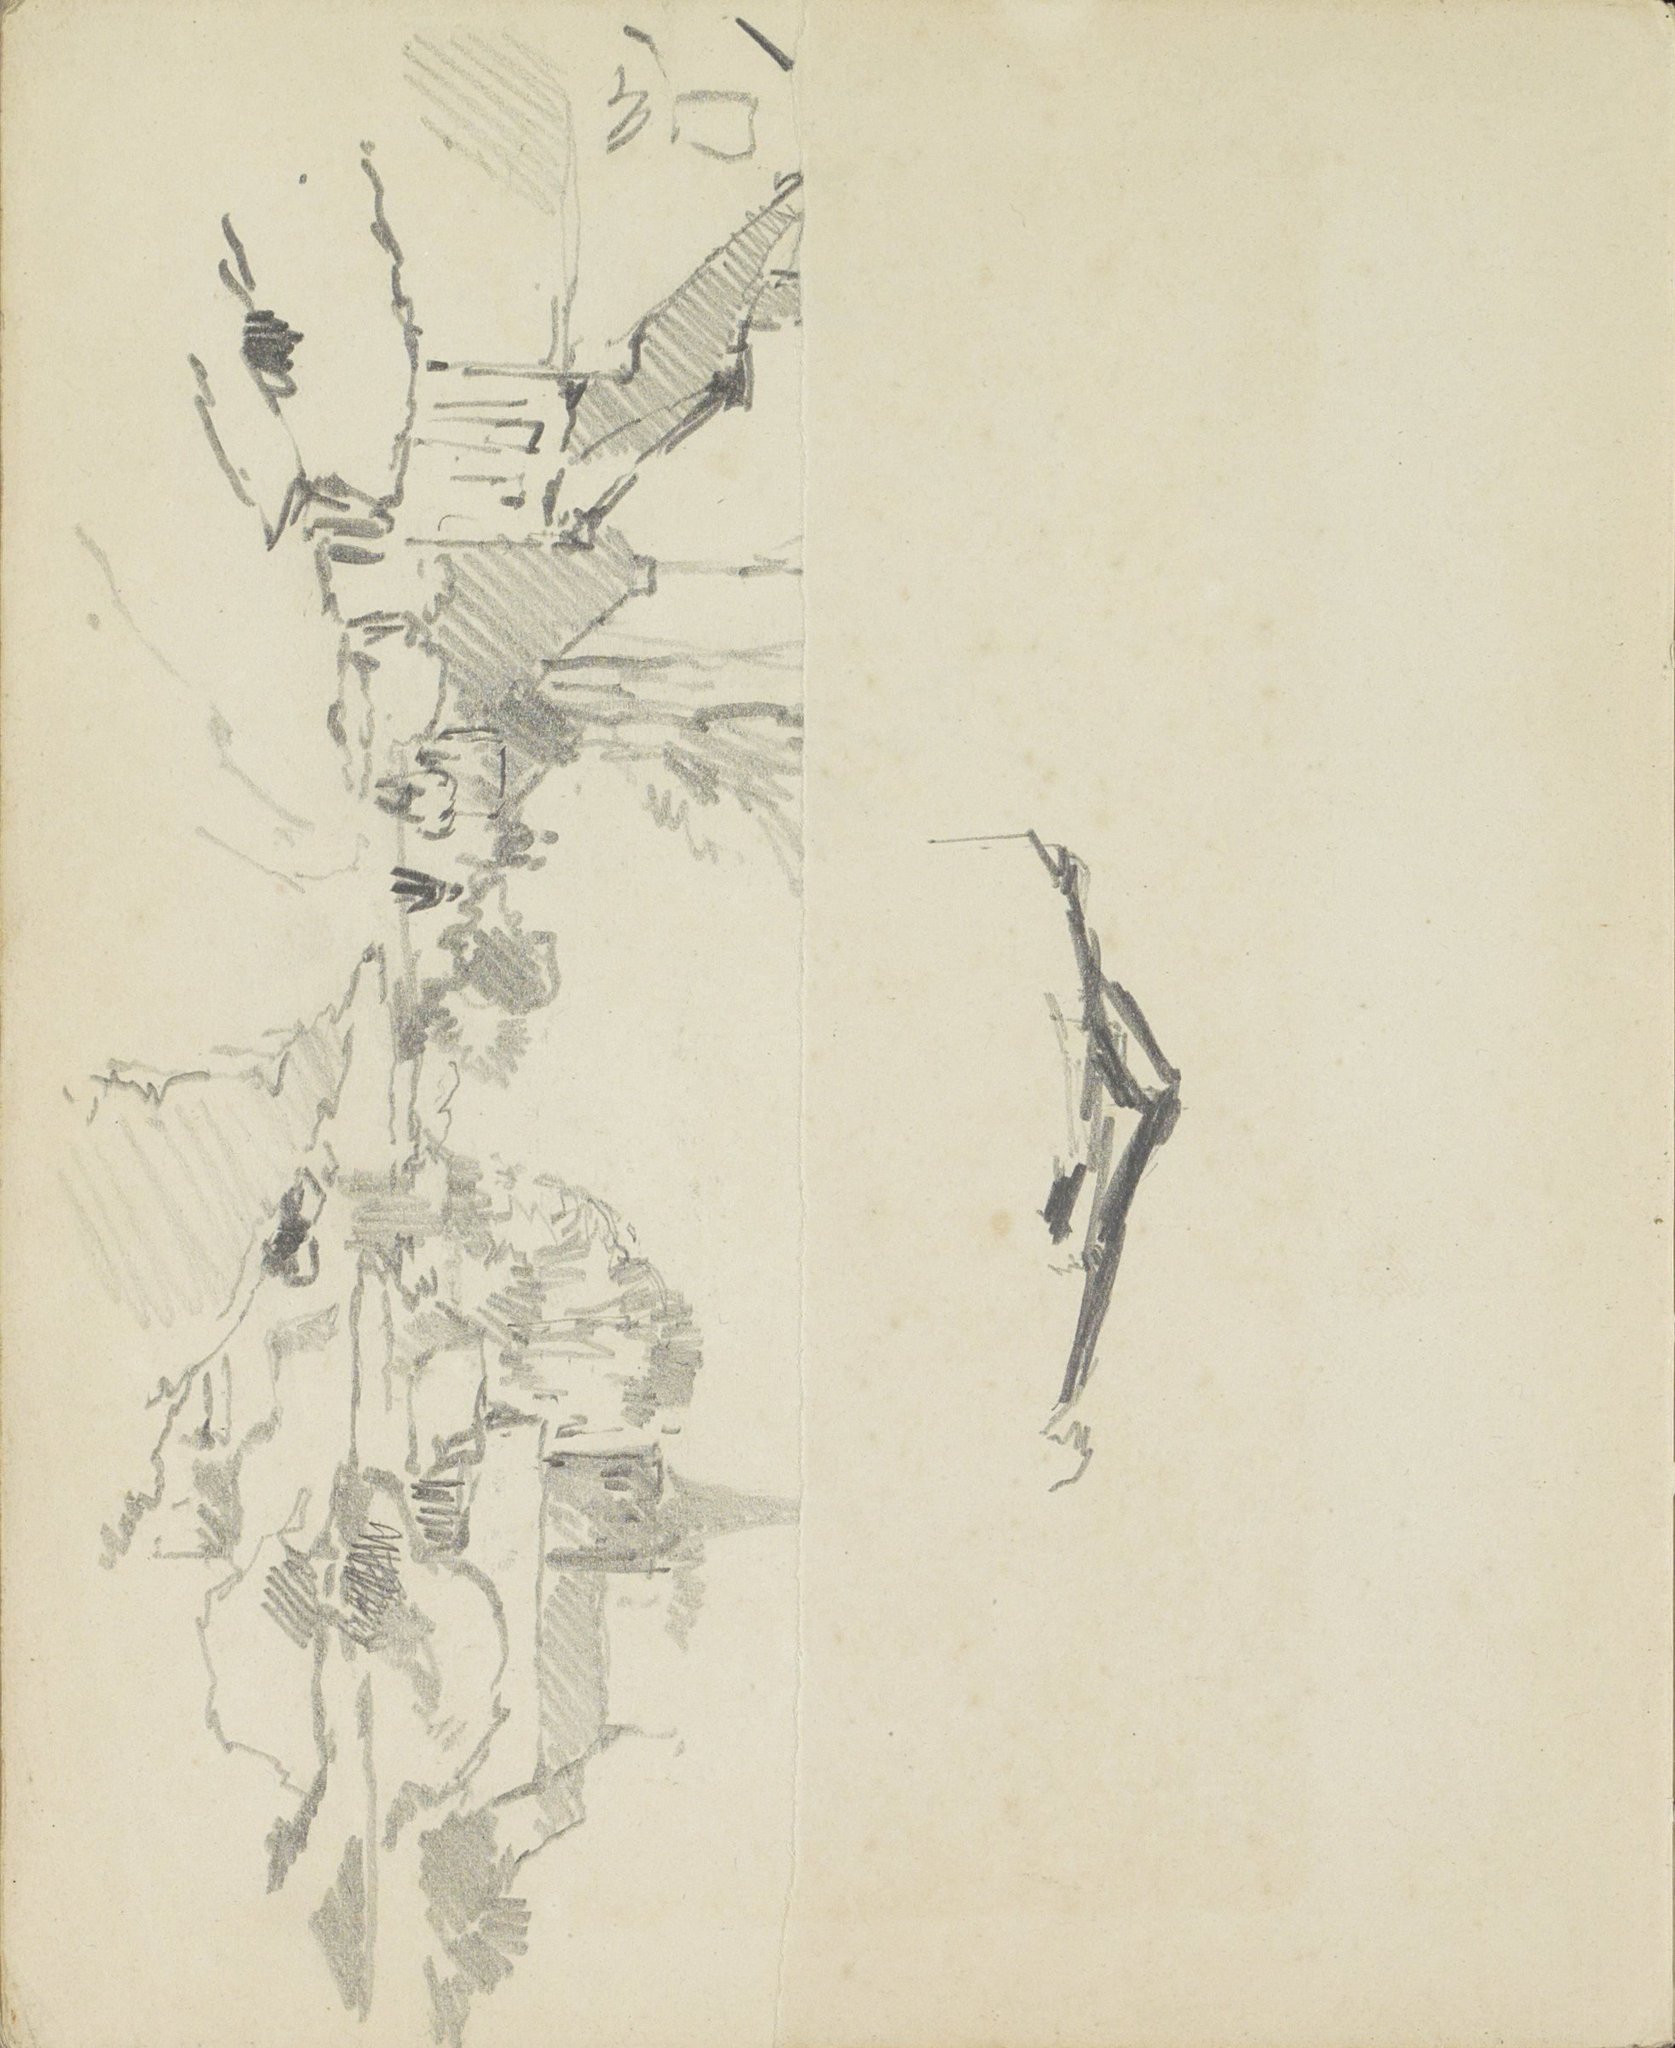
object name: sketchbook leaf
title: Studie, mogelijk een dak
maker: cornelis vreedenburgh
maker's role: draughtsman, print maker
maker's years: 1880-1946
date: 1890-1946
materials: paper, pencil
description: Blad 75 verso uit een schetsboek met 76 bladen.